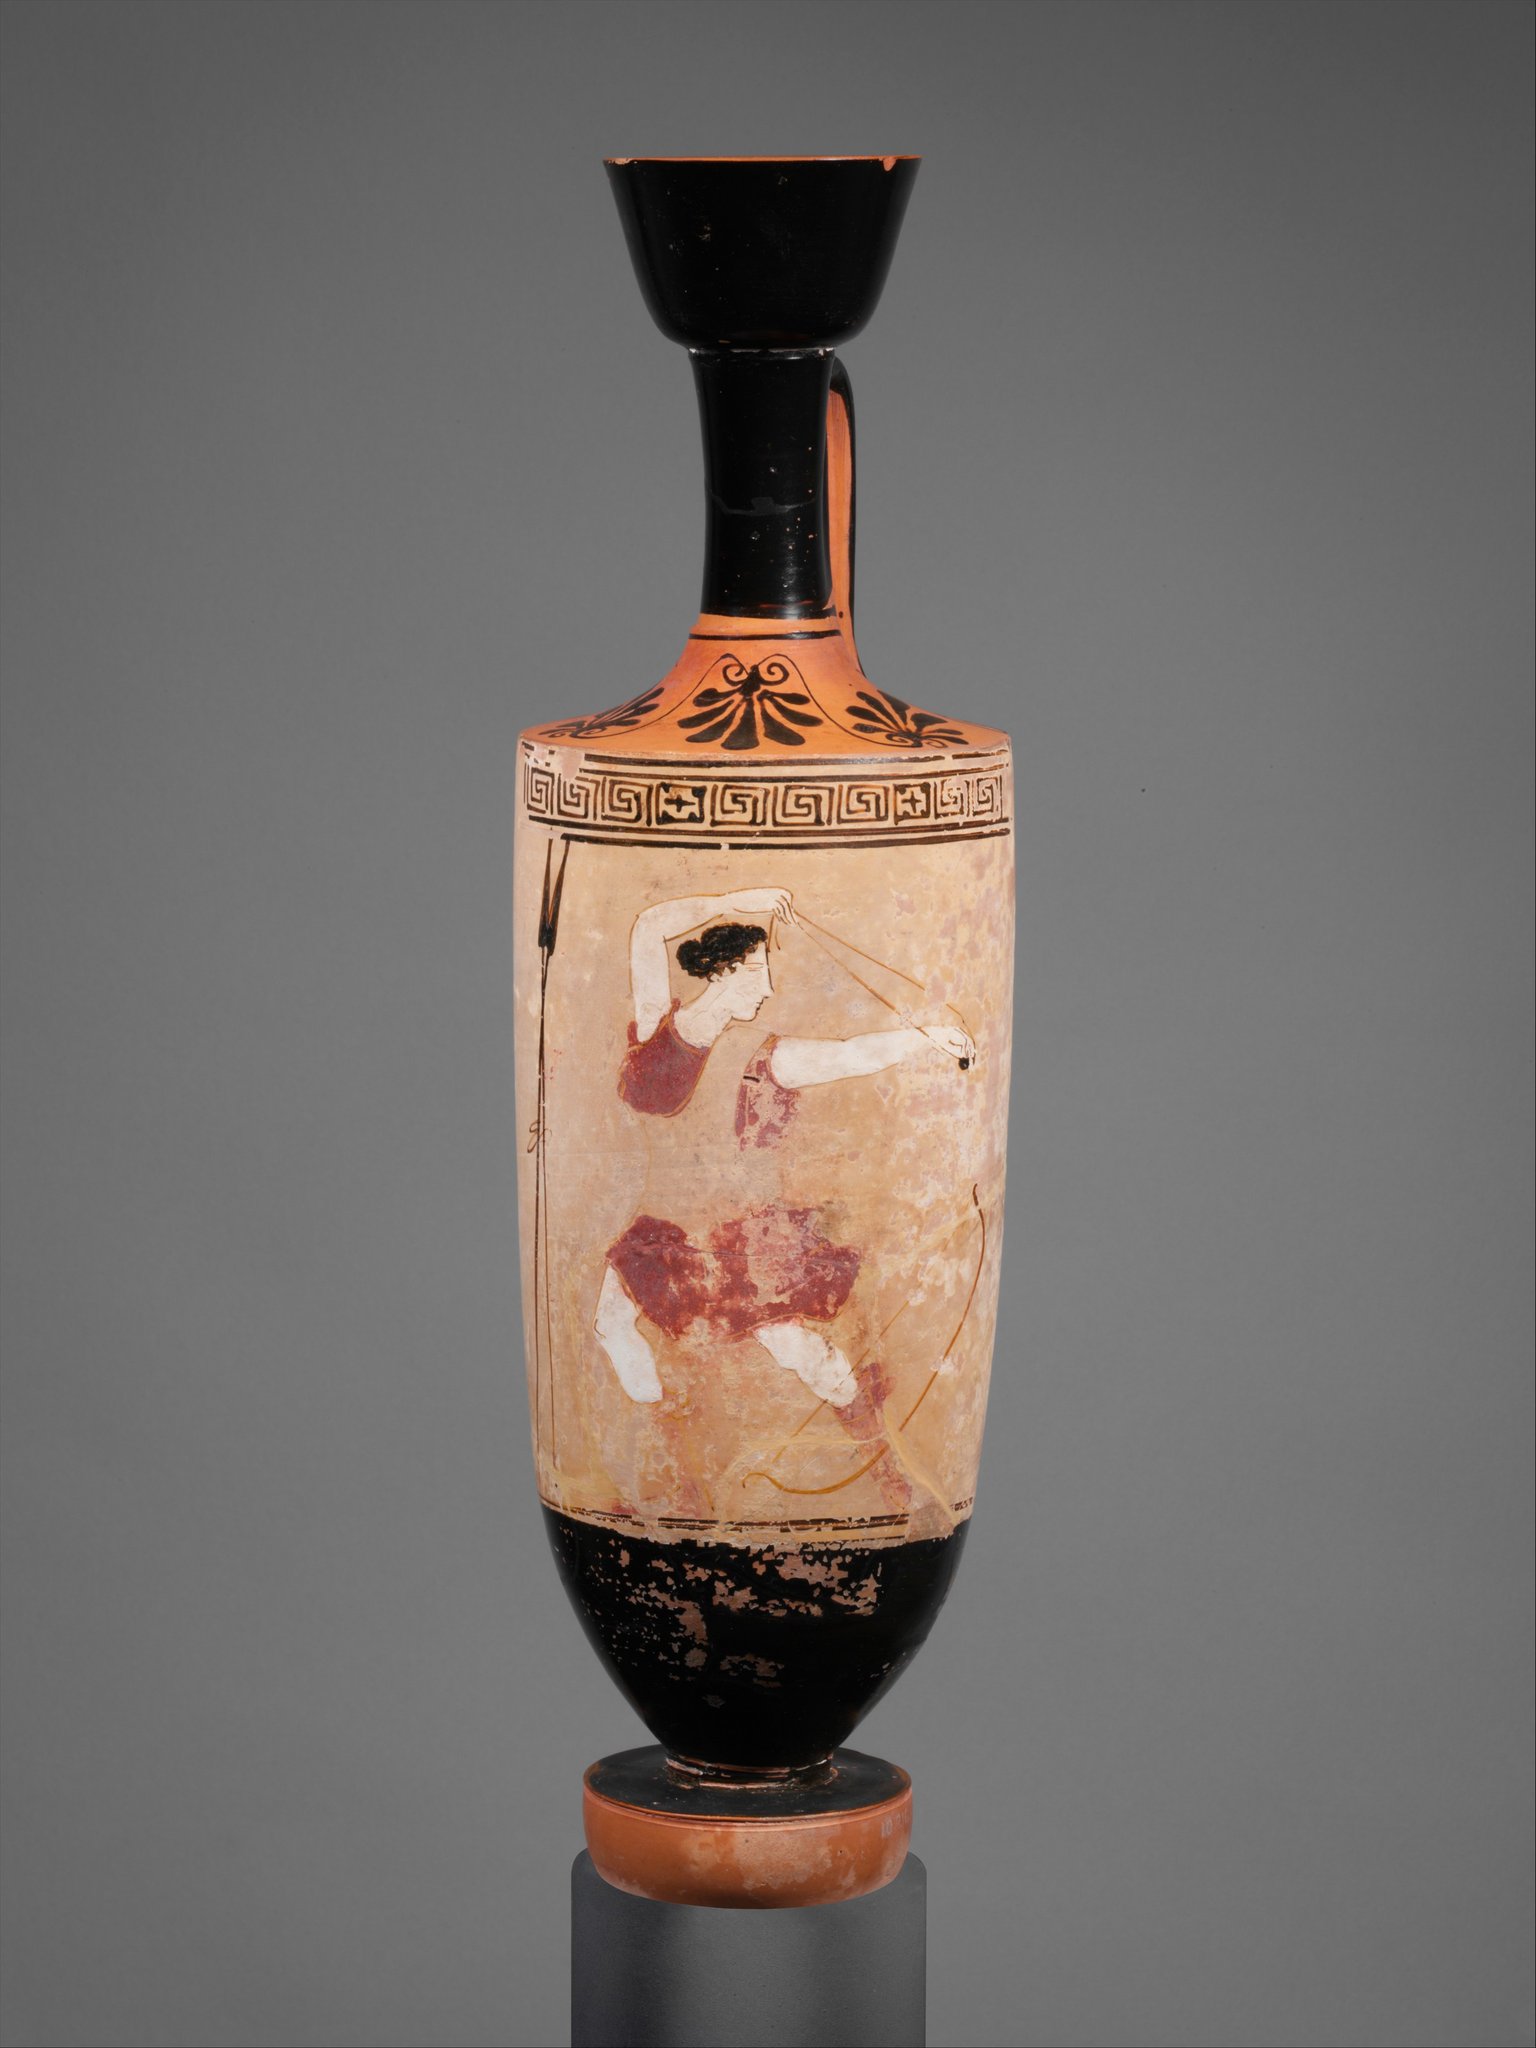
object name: lekythos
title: Terracotta lekythos (oil flask)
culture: greek, attic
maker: klügmann painter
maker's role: artist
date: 440 BCE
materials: terracotta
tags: women,amazons